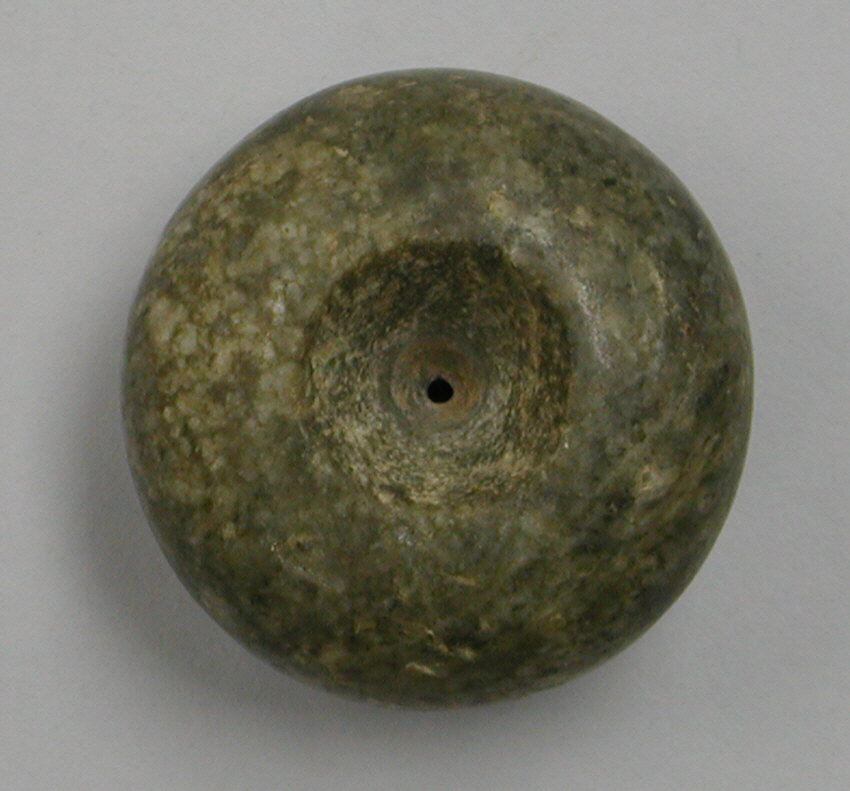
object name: weight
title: Stone Weight or Bead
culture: mezcala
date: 1-800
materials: stone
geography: mexico